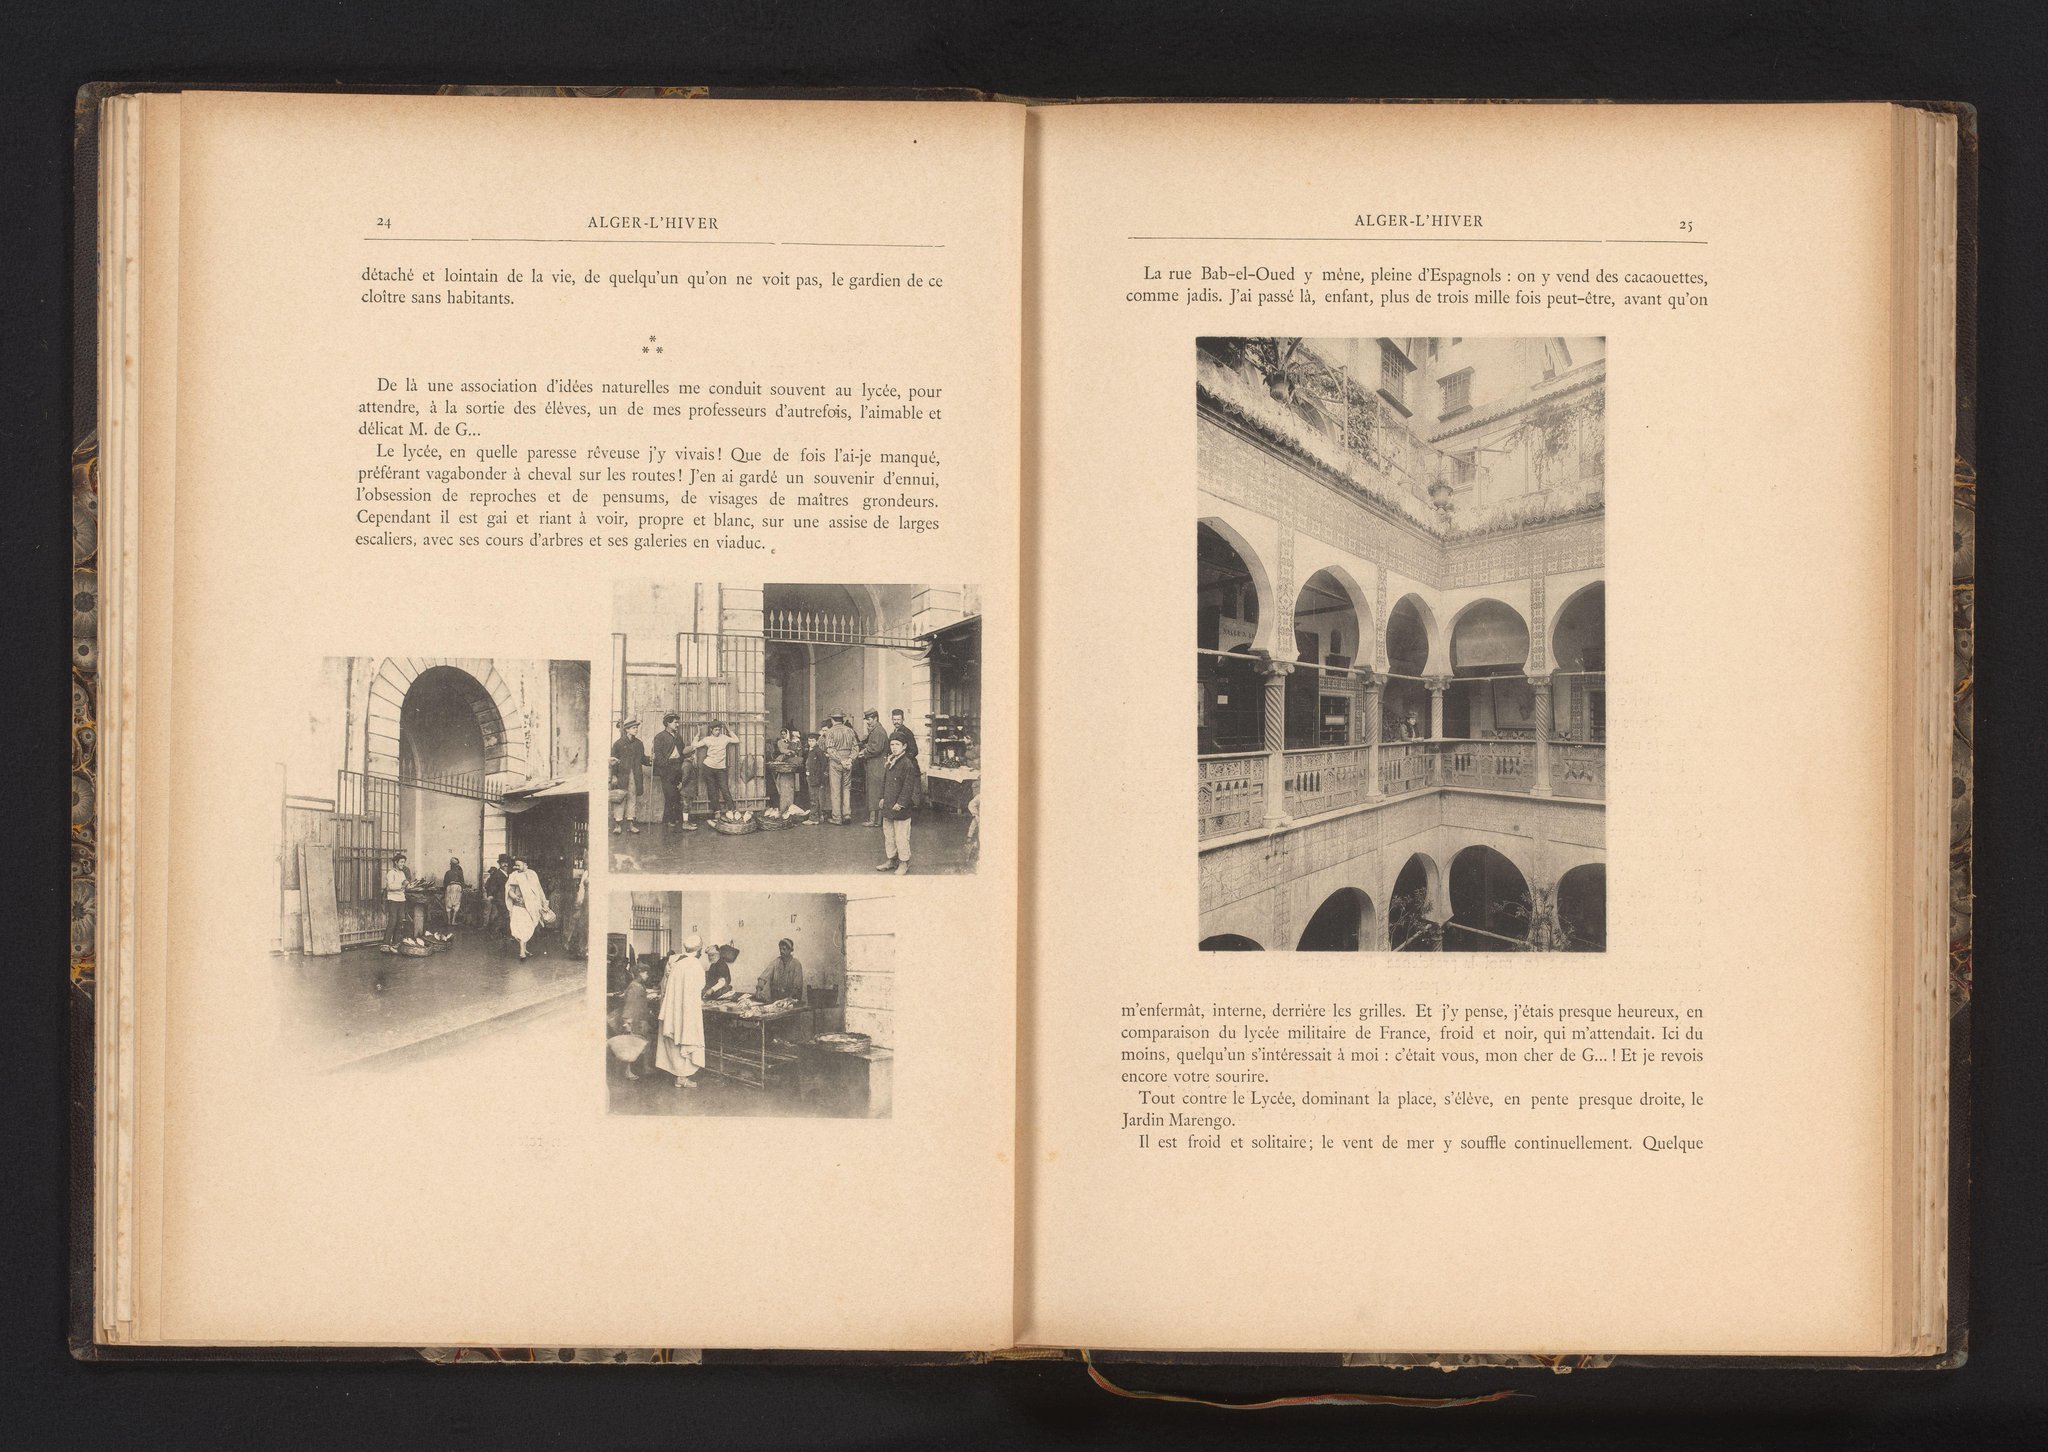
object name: photomechanical print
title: Drie afbeeldingen van handelsactiviteiten in de straten van Algiers, Algerije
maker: jules gervais-courtellemont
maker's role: fotograaf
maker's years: 1863-1931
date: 1888-1893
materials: paper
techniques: photograph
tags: adult man, stall, booth (~ market), street